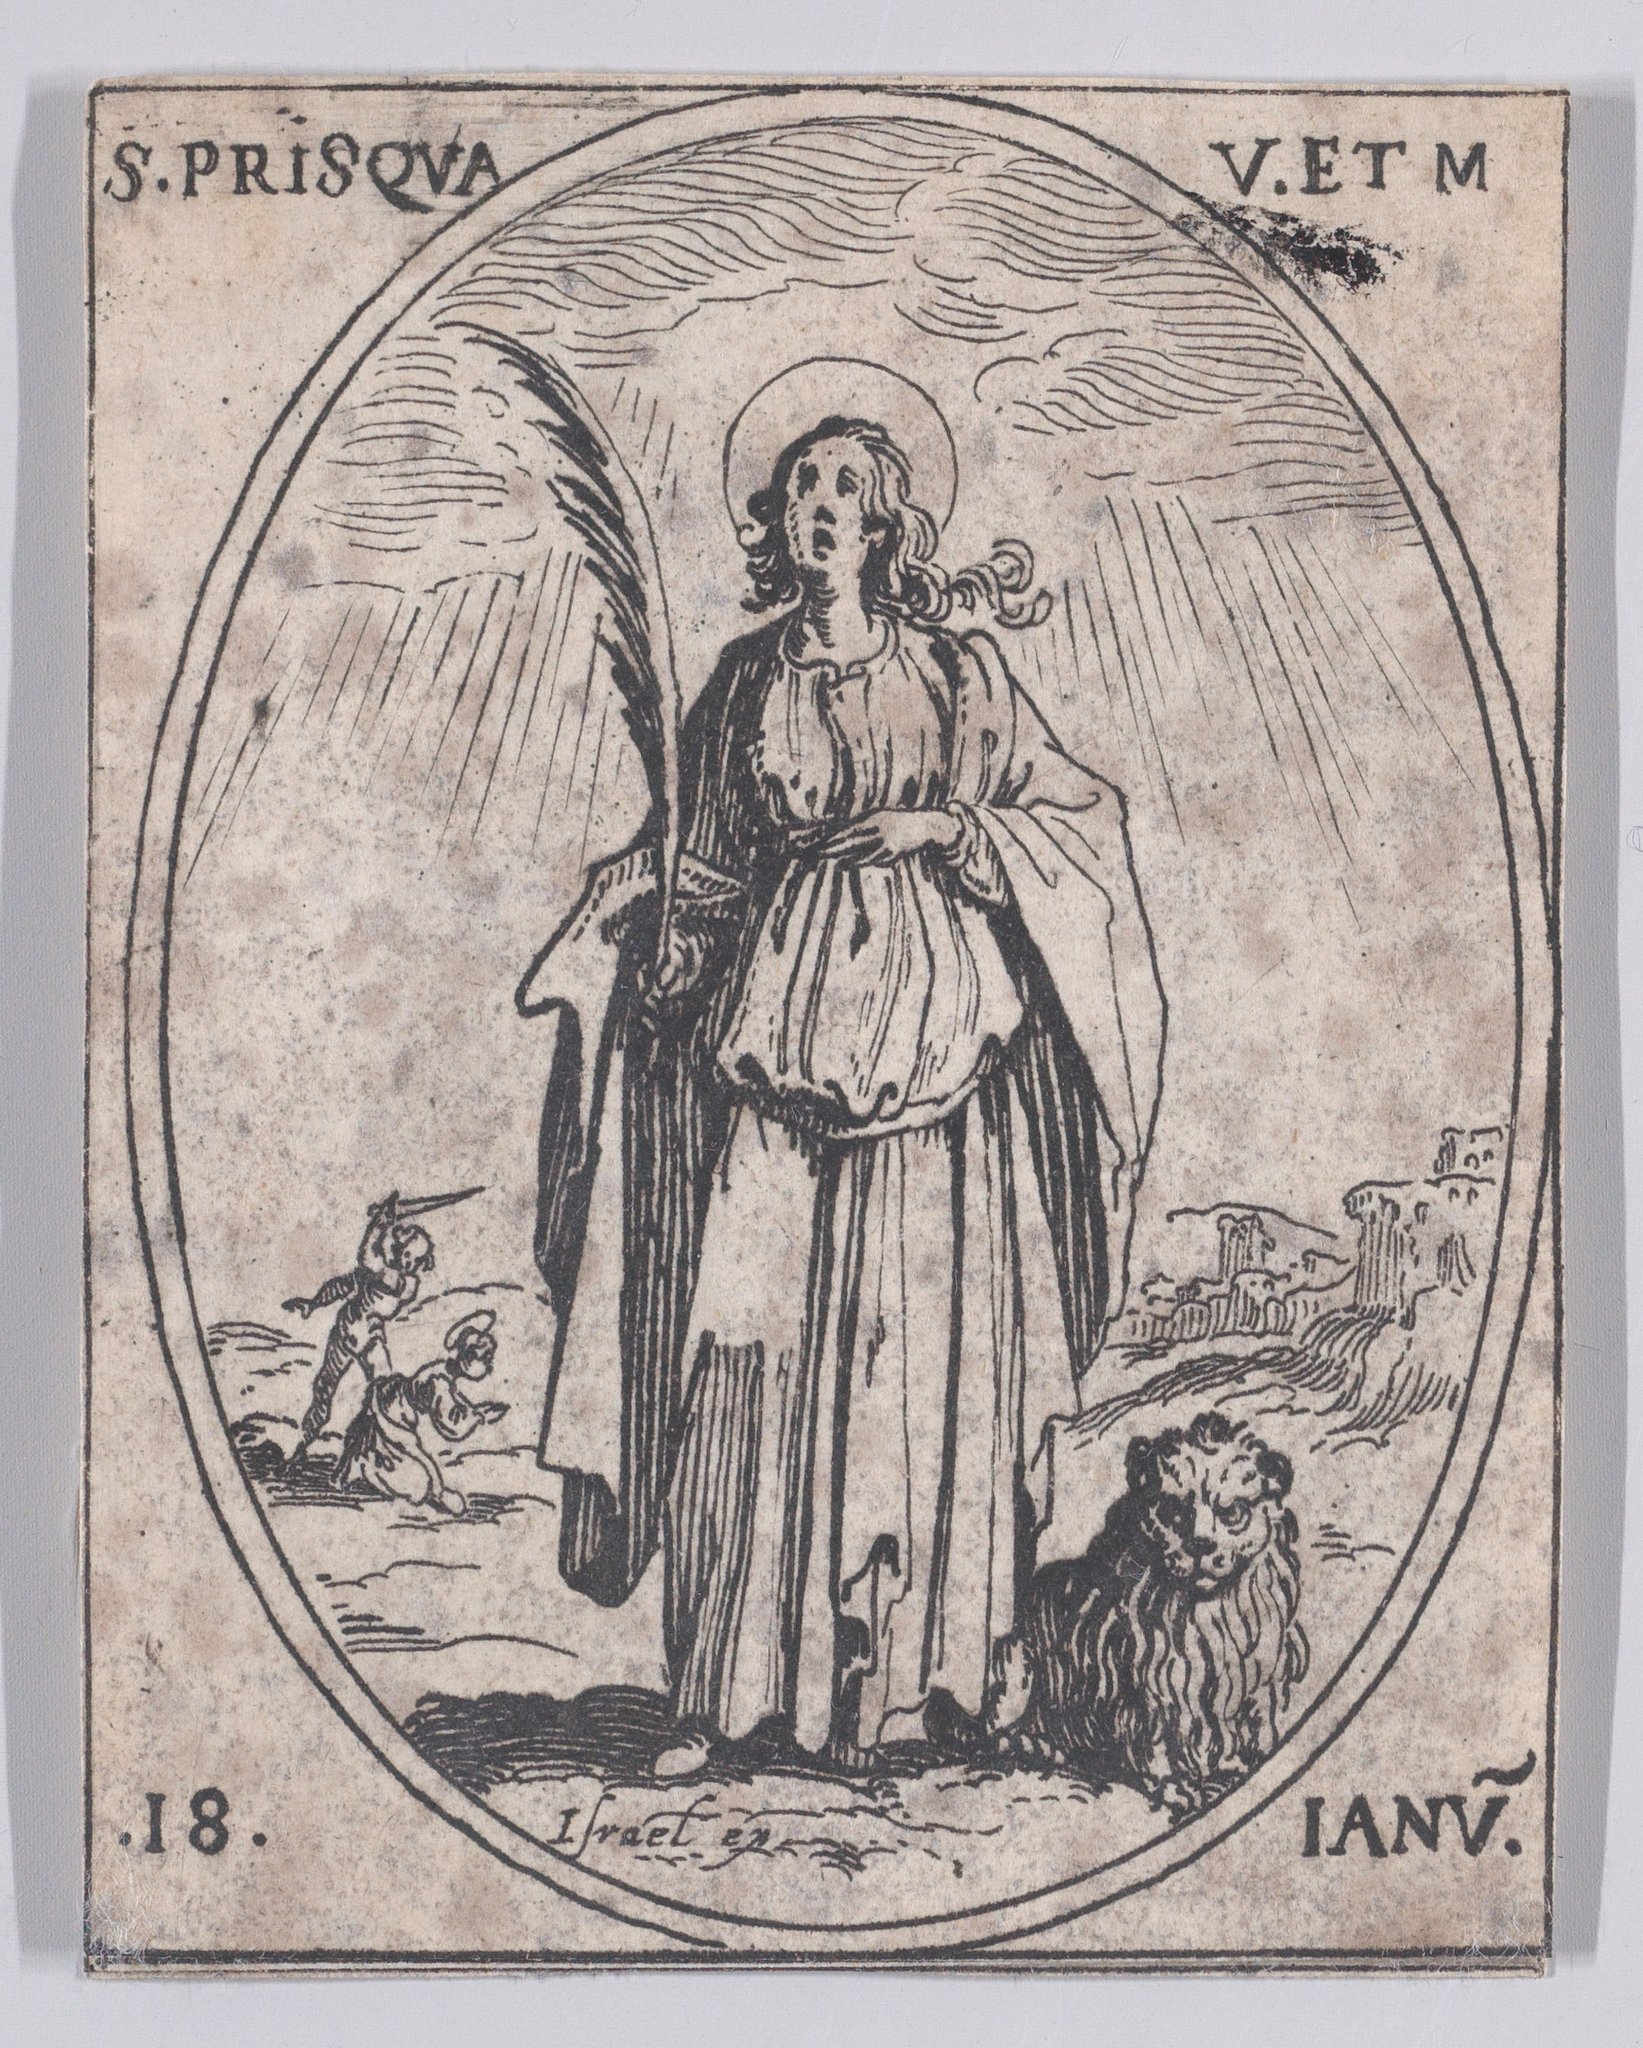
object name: print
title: Ste. Prisque, vierge et martyre (St. Prisca, Virgin and Martyr), January 18th, from "Les Images De Tous Les Saincts et Saintes de L'Année" (Images of All of the Saints and Feast Days of the Year)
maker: jacques callot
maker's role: artist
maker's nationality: french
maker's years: 1592-1635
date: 1636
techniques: etching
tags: women,lions,saints